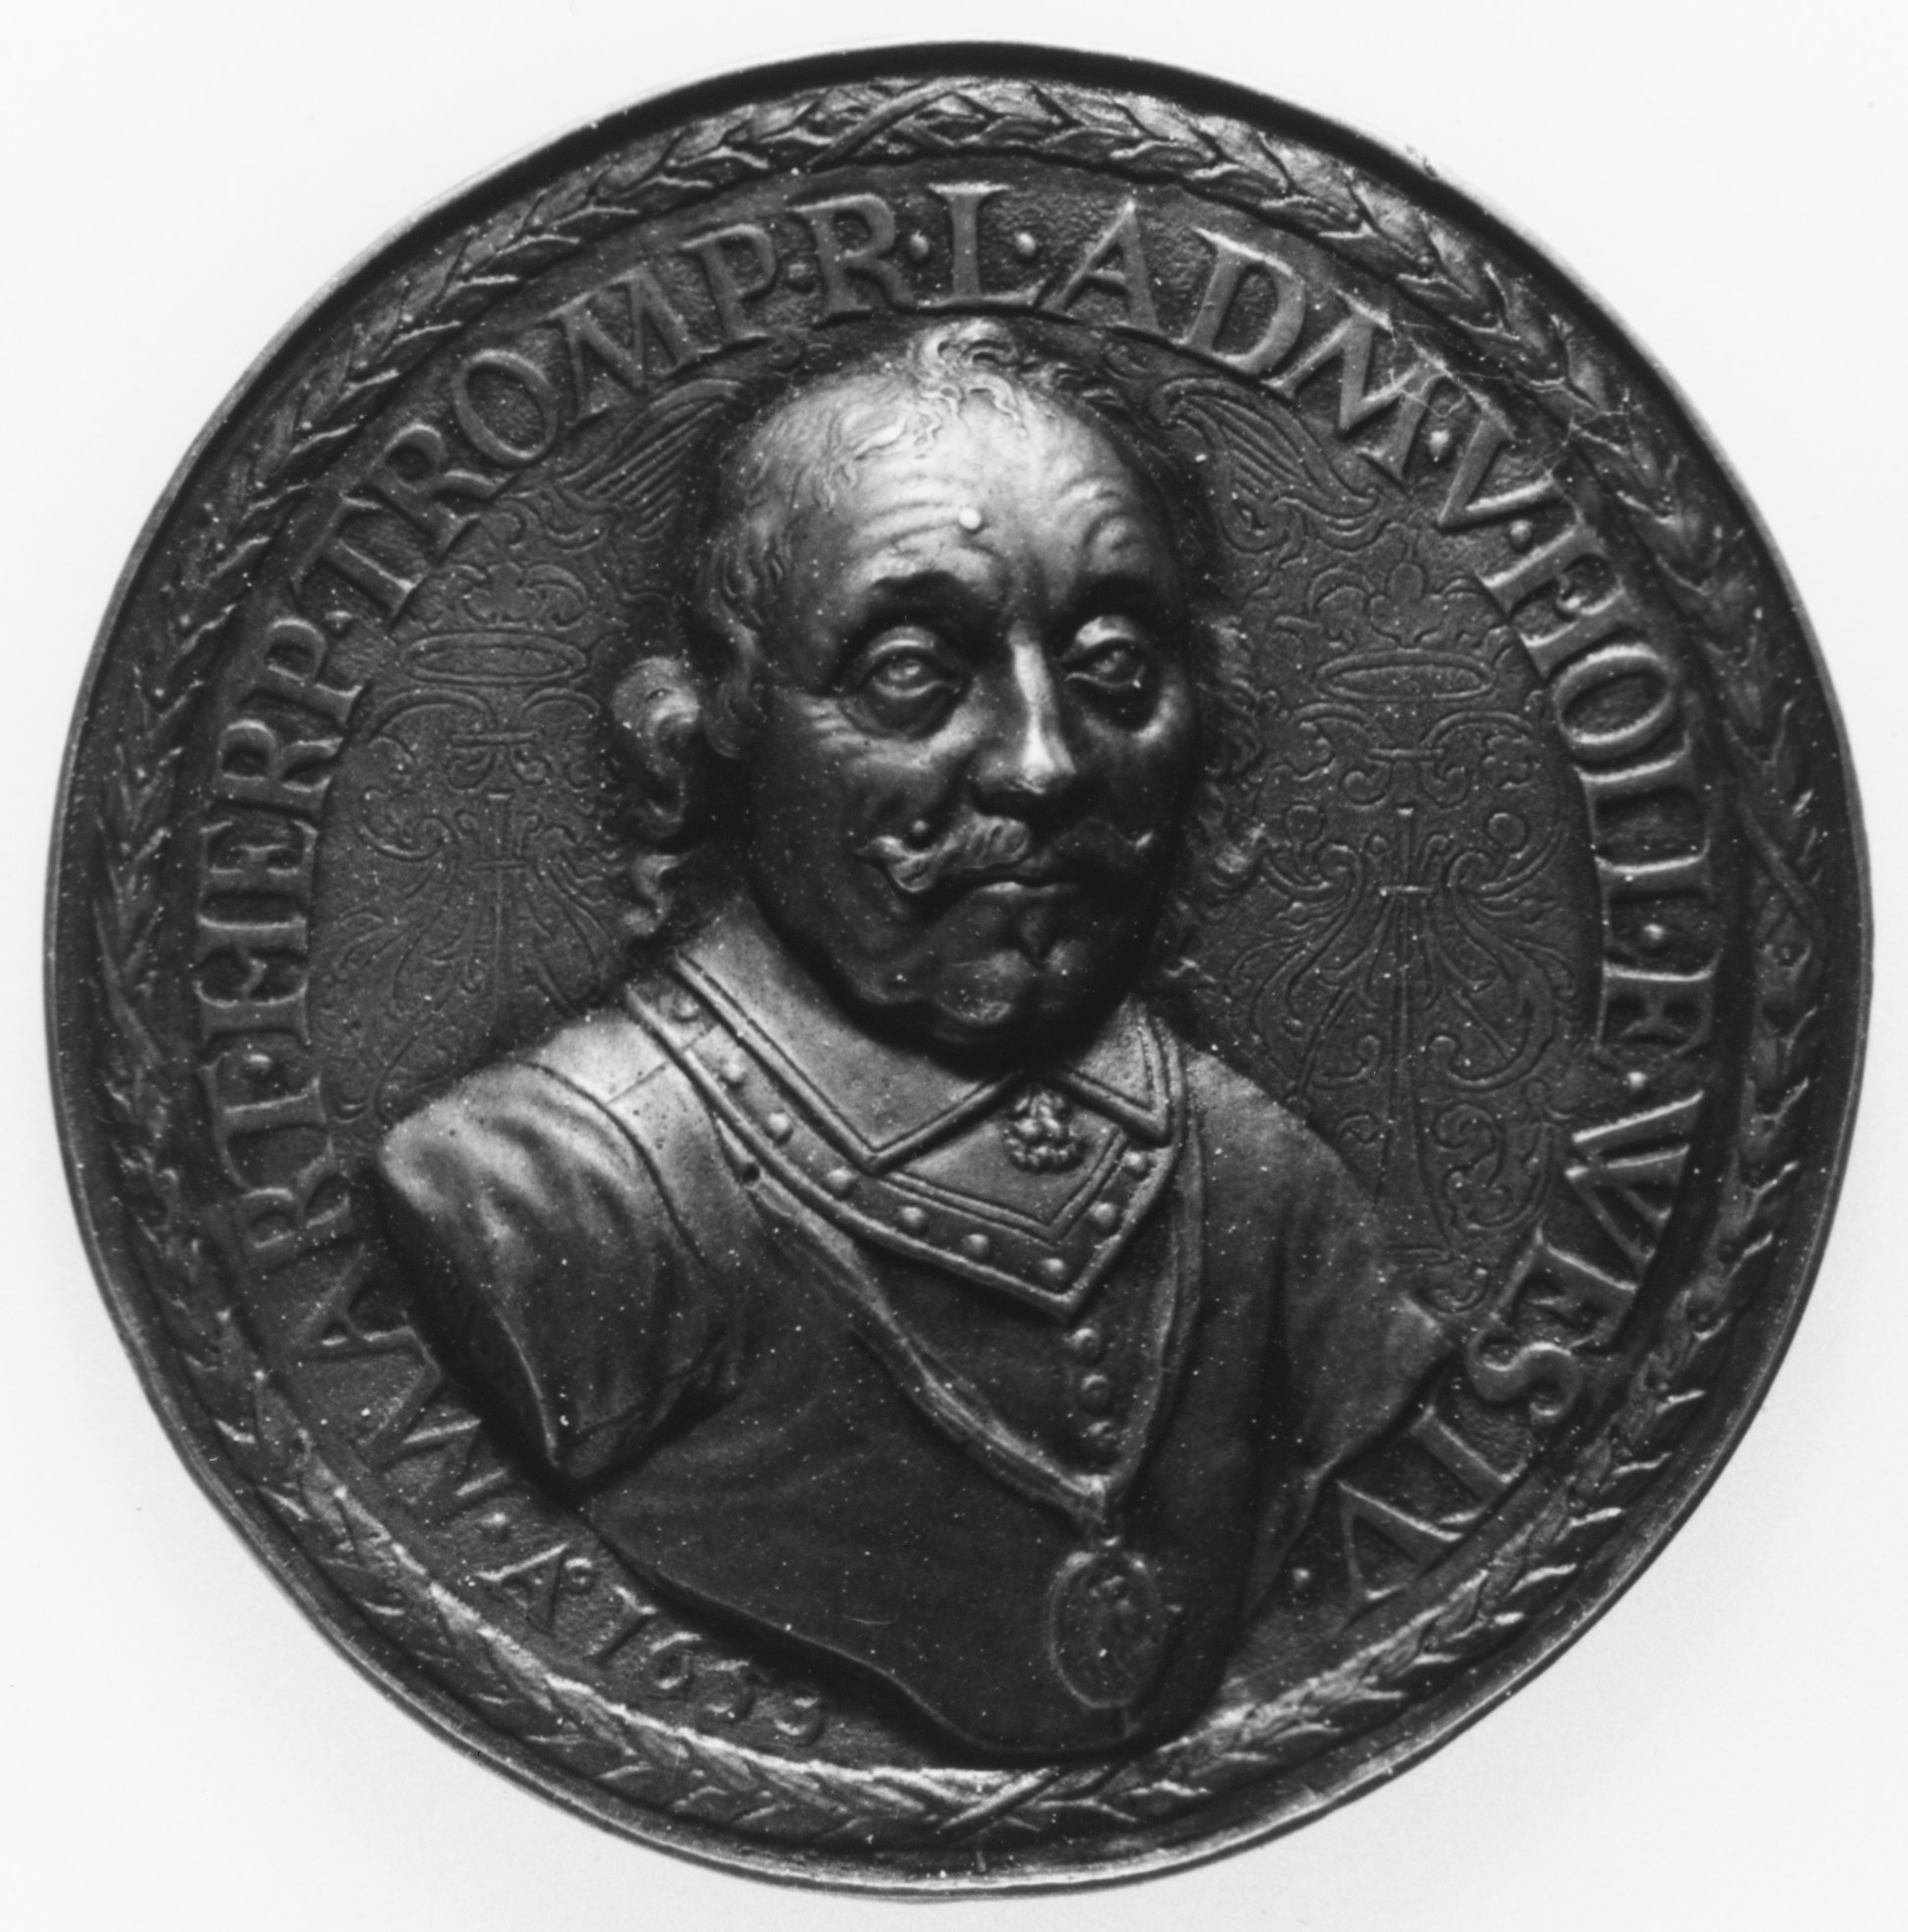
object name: medal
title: Martin Harpertzoon Tromp (1597–1653)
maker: pieter van abeele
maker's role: artist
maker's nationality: dutch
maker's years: 1608-1684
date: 1653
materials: silver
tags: men,portraits